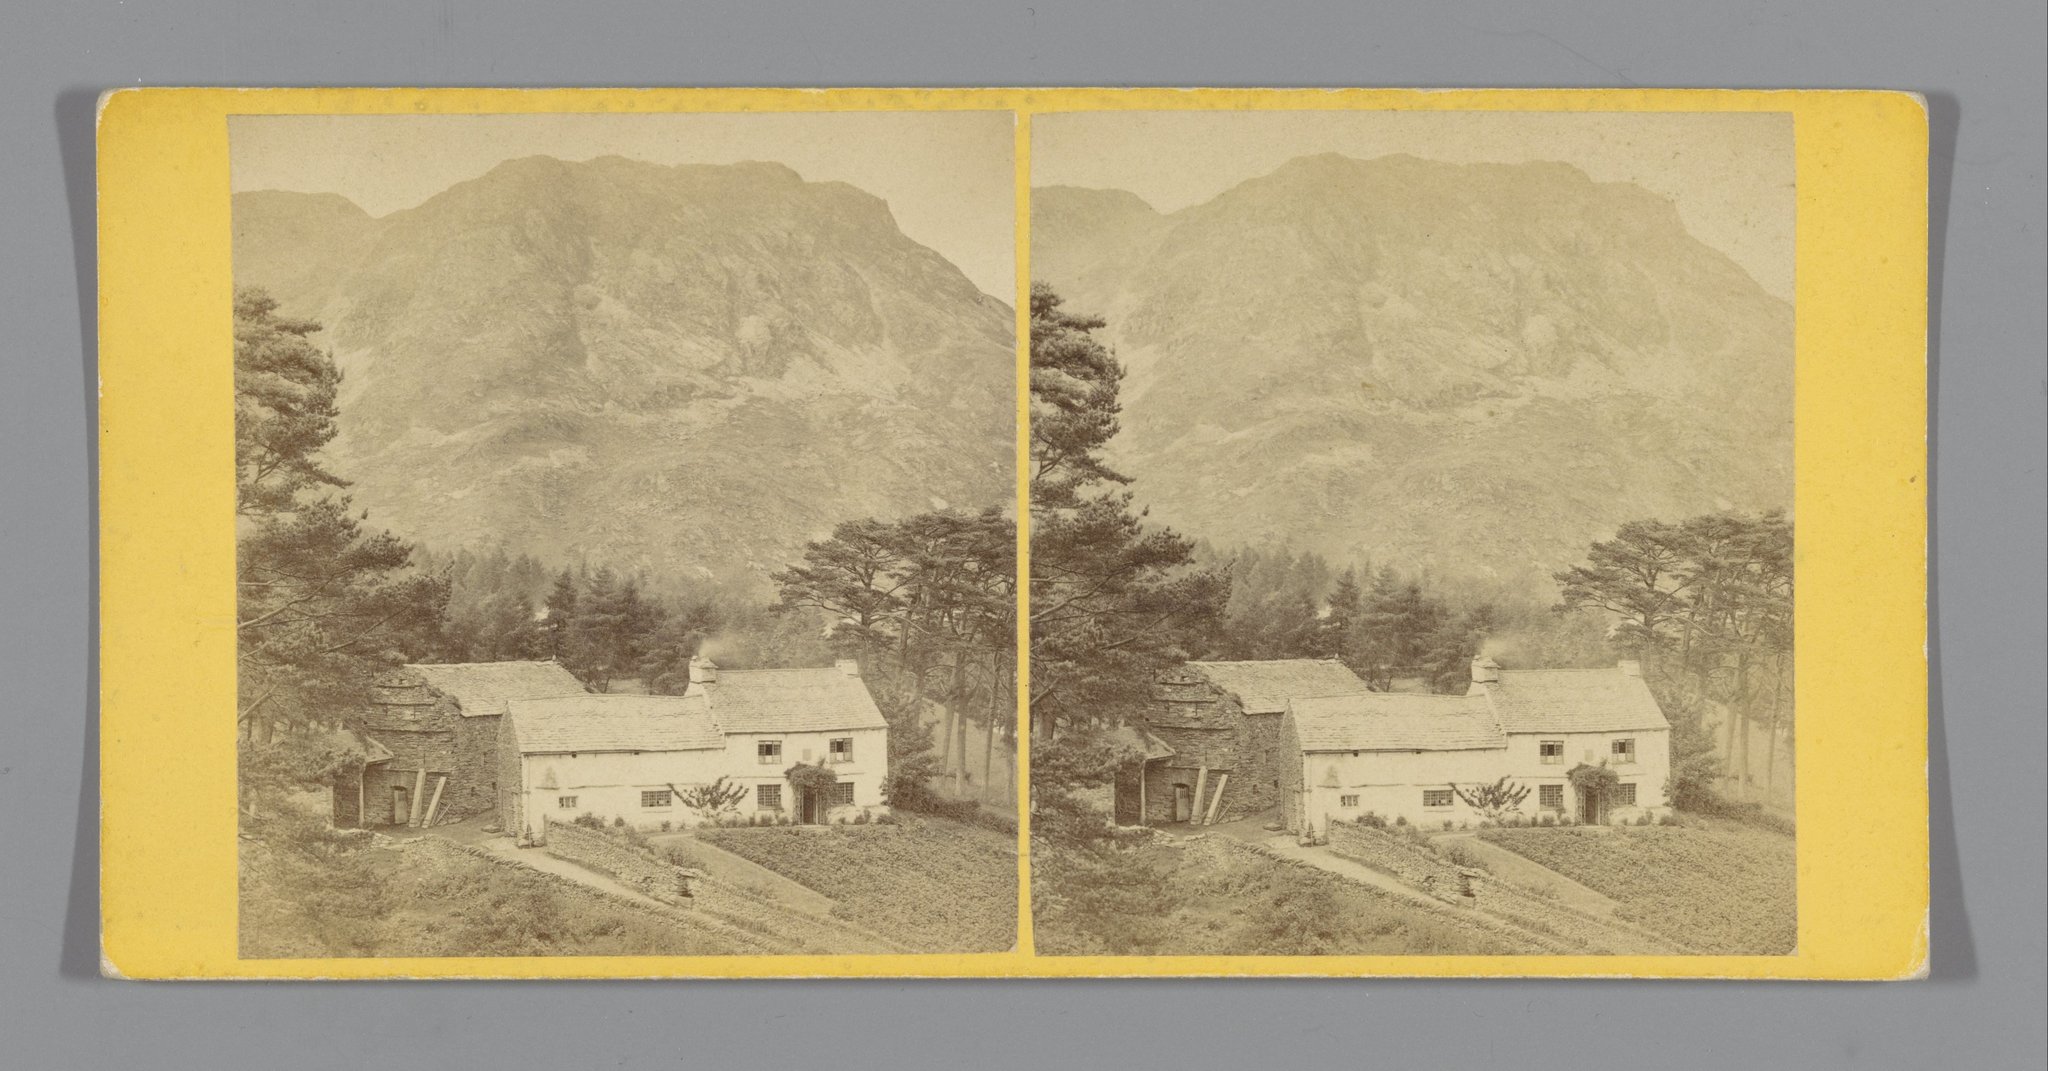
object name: stereograph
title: Gebouw te Coniston, met op de achtergrond een berg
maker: george washington wilson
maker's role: publisher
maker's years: 1823-1893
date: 1850-1880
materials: cardboard, photographic support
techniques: albumen print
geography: coniston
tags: façade (of house or building), mountains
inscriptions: number: ‘No 11’, name: ‘Registered. G. W. Wilson, Photographer, Aberdeen.’, number: ‘No. 560.’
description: Het object RP-F-F04847 is vermoedelijk tijdens dezelfde fotografeersessie gemaakt.